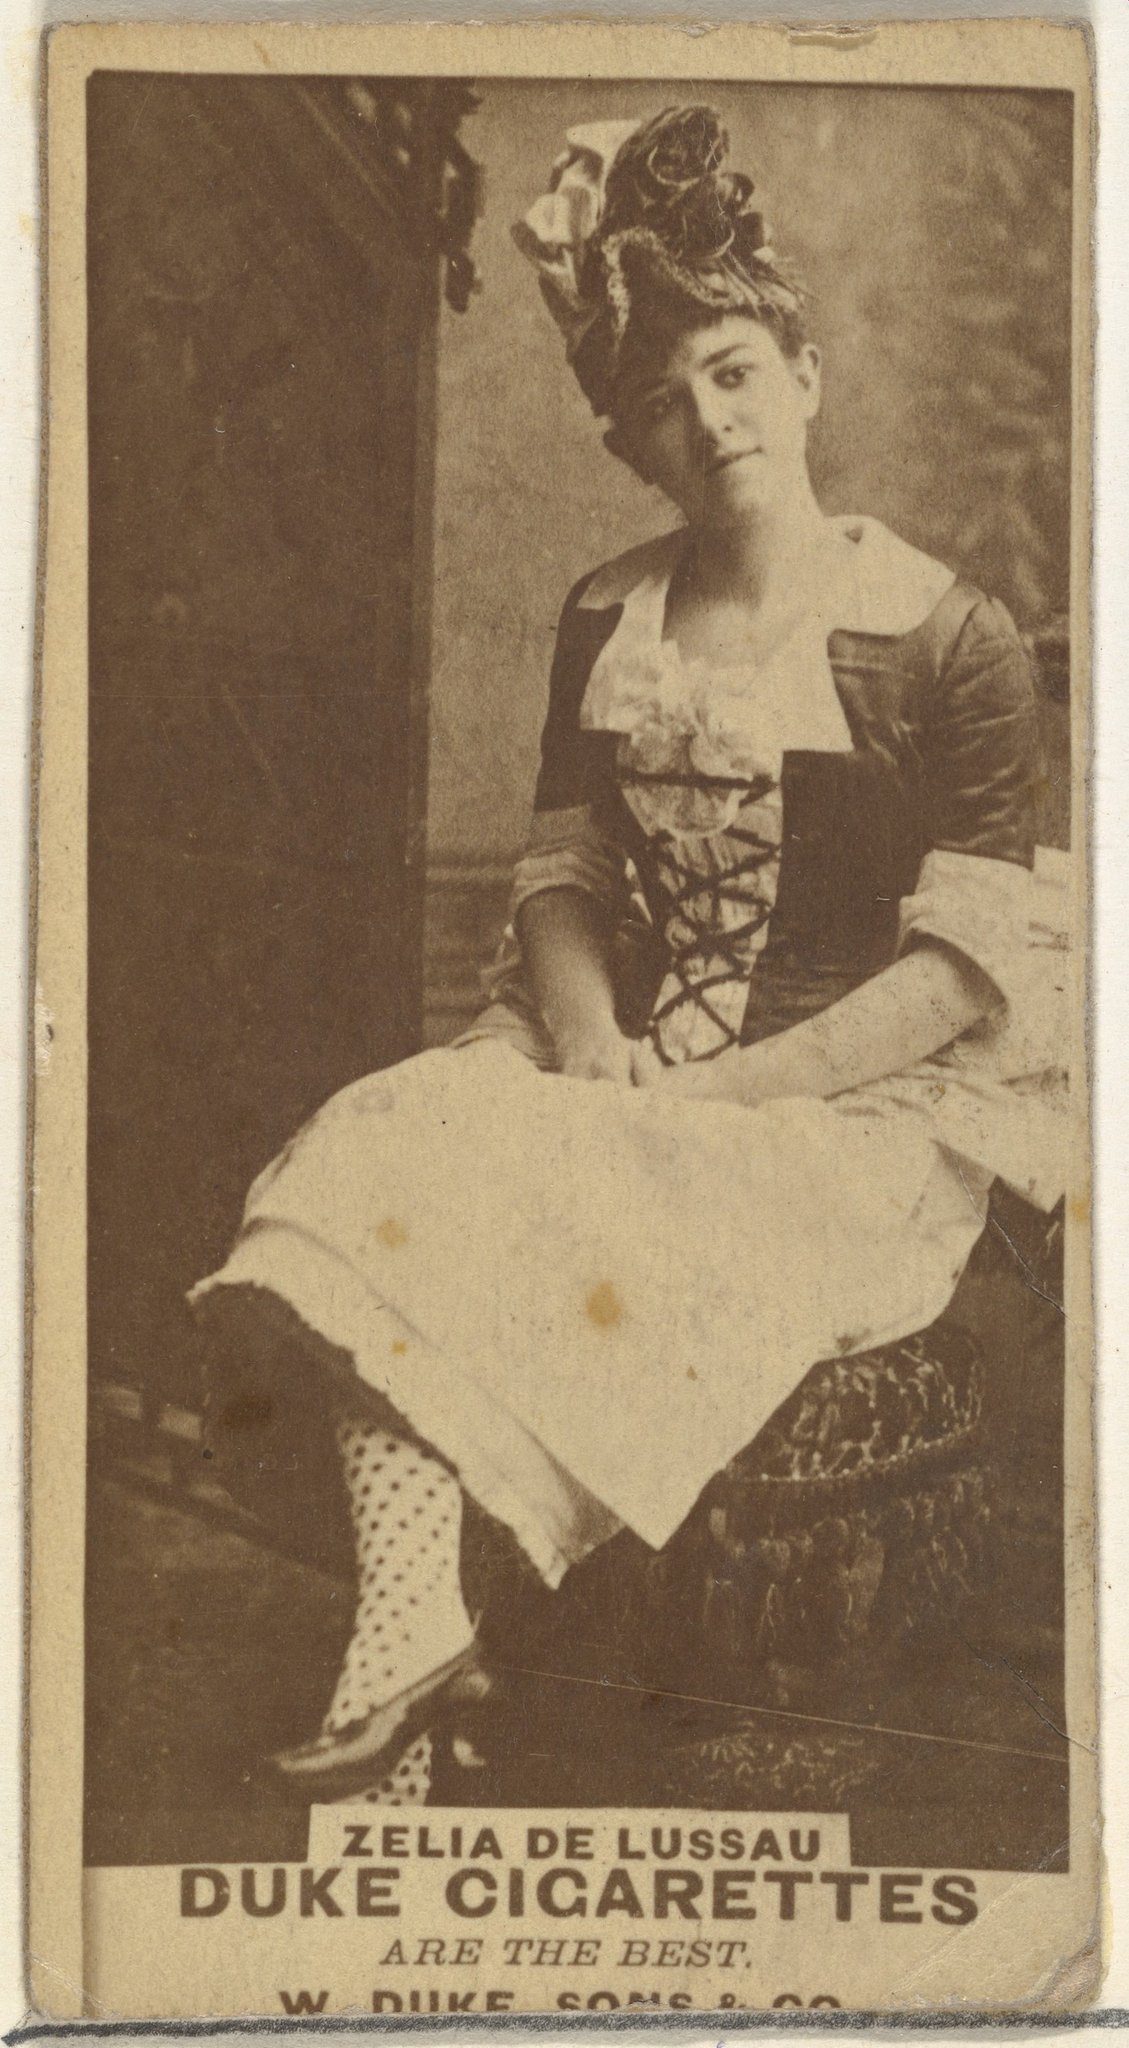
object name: photograph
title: Zelia De Lussau, from the Actors and Actresses series (N145-7) issued by Duke Sons & Co. to promote Duke Cigarettes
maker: w. duke, sons & co.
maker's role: publisher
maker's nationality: american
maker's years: 1870-1920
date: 1880-1889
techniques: albumen silver print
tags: portraits,women,actresses